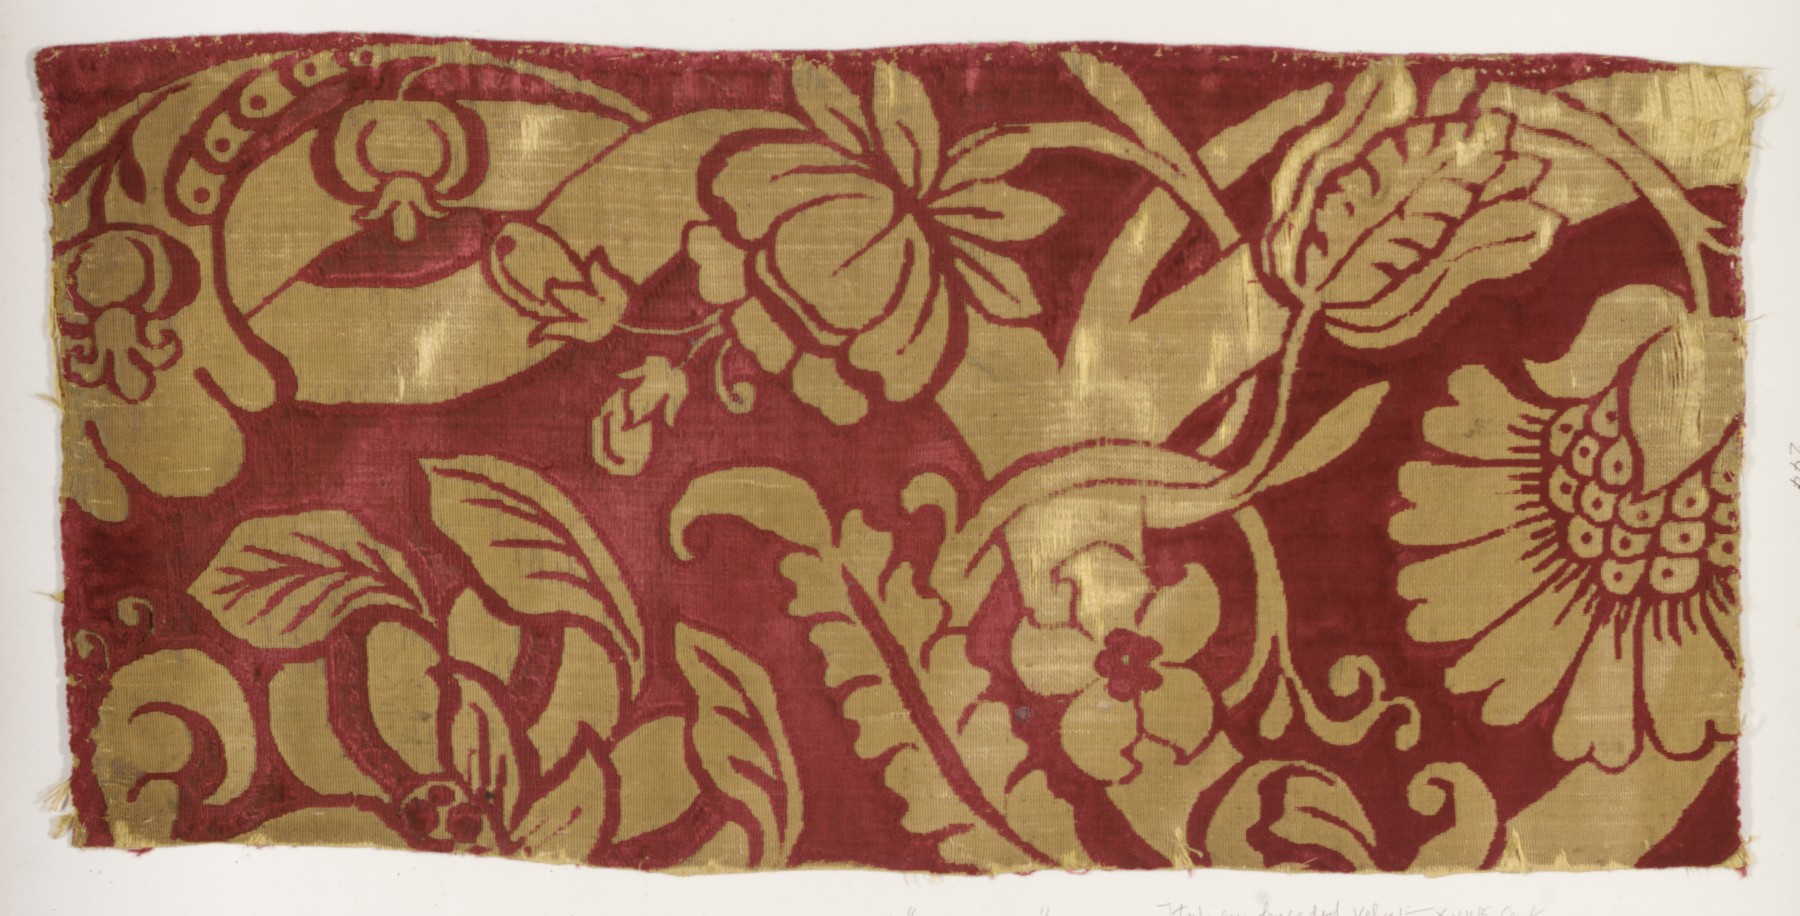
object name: fragment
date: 1601-1700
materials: metal thread, silk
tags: flowers,leaves